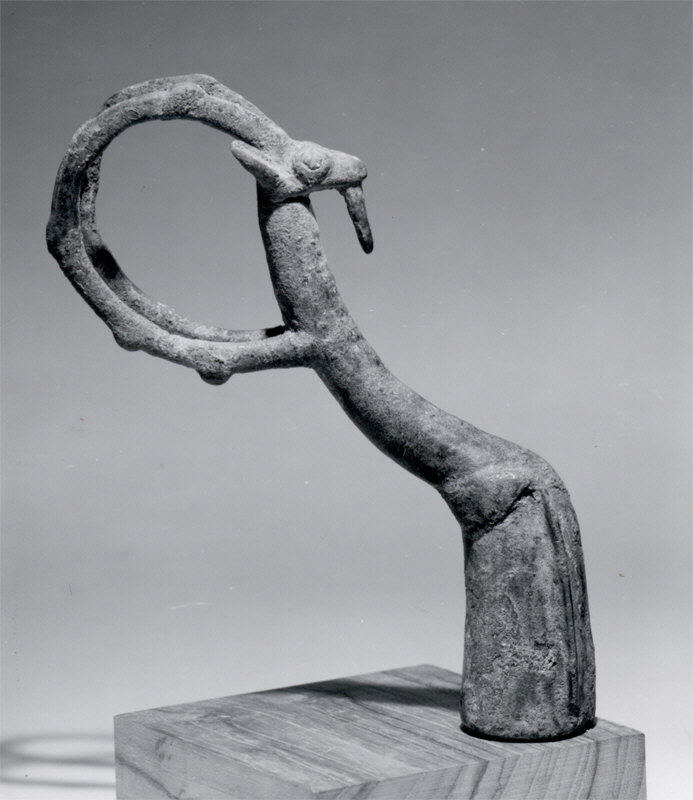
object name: whetstone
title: Whetstone handle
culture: iranian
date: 900-601 BCE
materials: bronze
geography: iran, probably from luristan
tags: animals